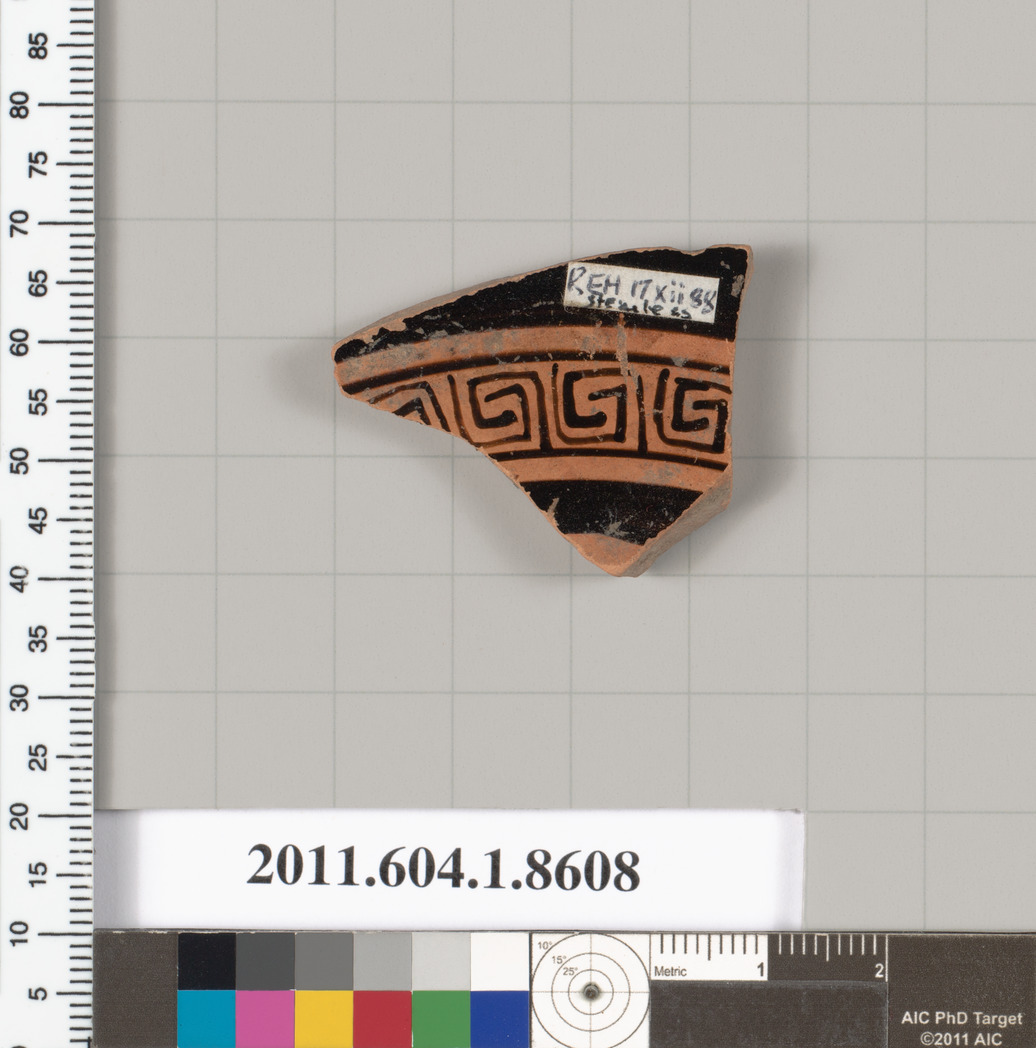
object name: kylix fragment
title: Terracotta fragment of a stemless kylix (drinking cup)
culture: greek, attic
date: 460-450 BCE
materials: terracotta